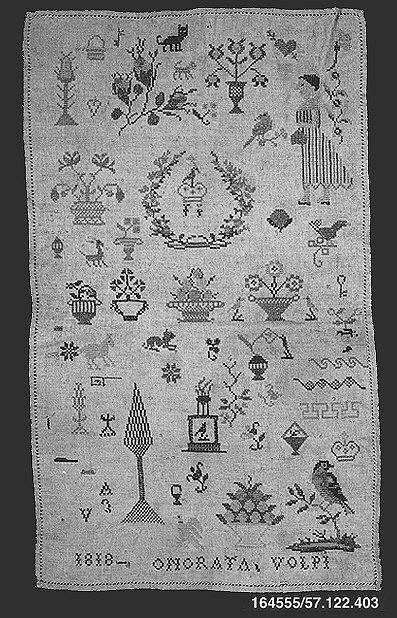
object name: sampler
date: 1818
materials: linen, silk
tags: birds,women